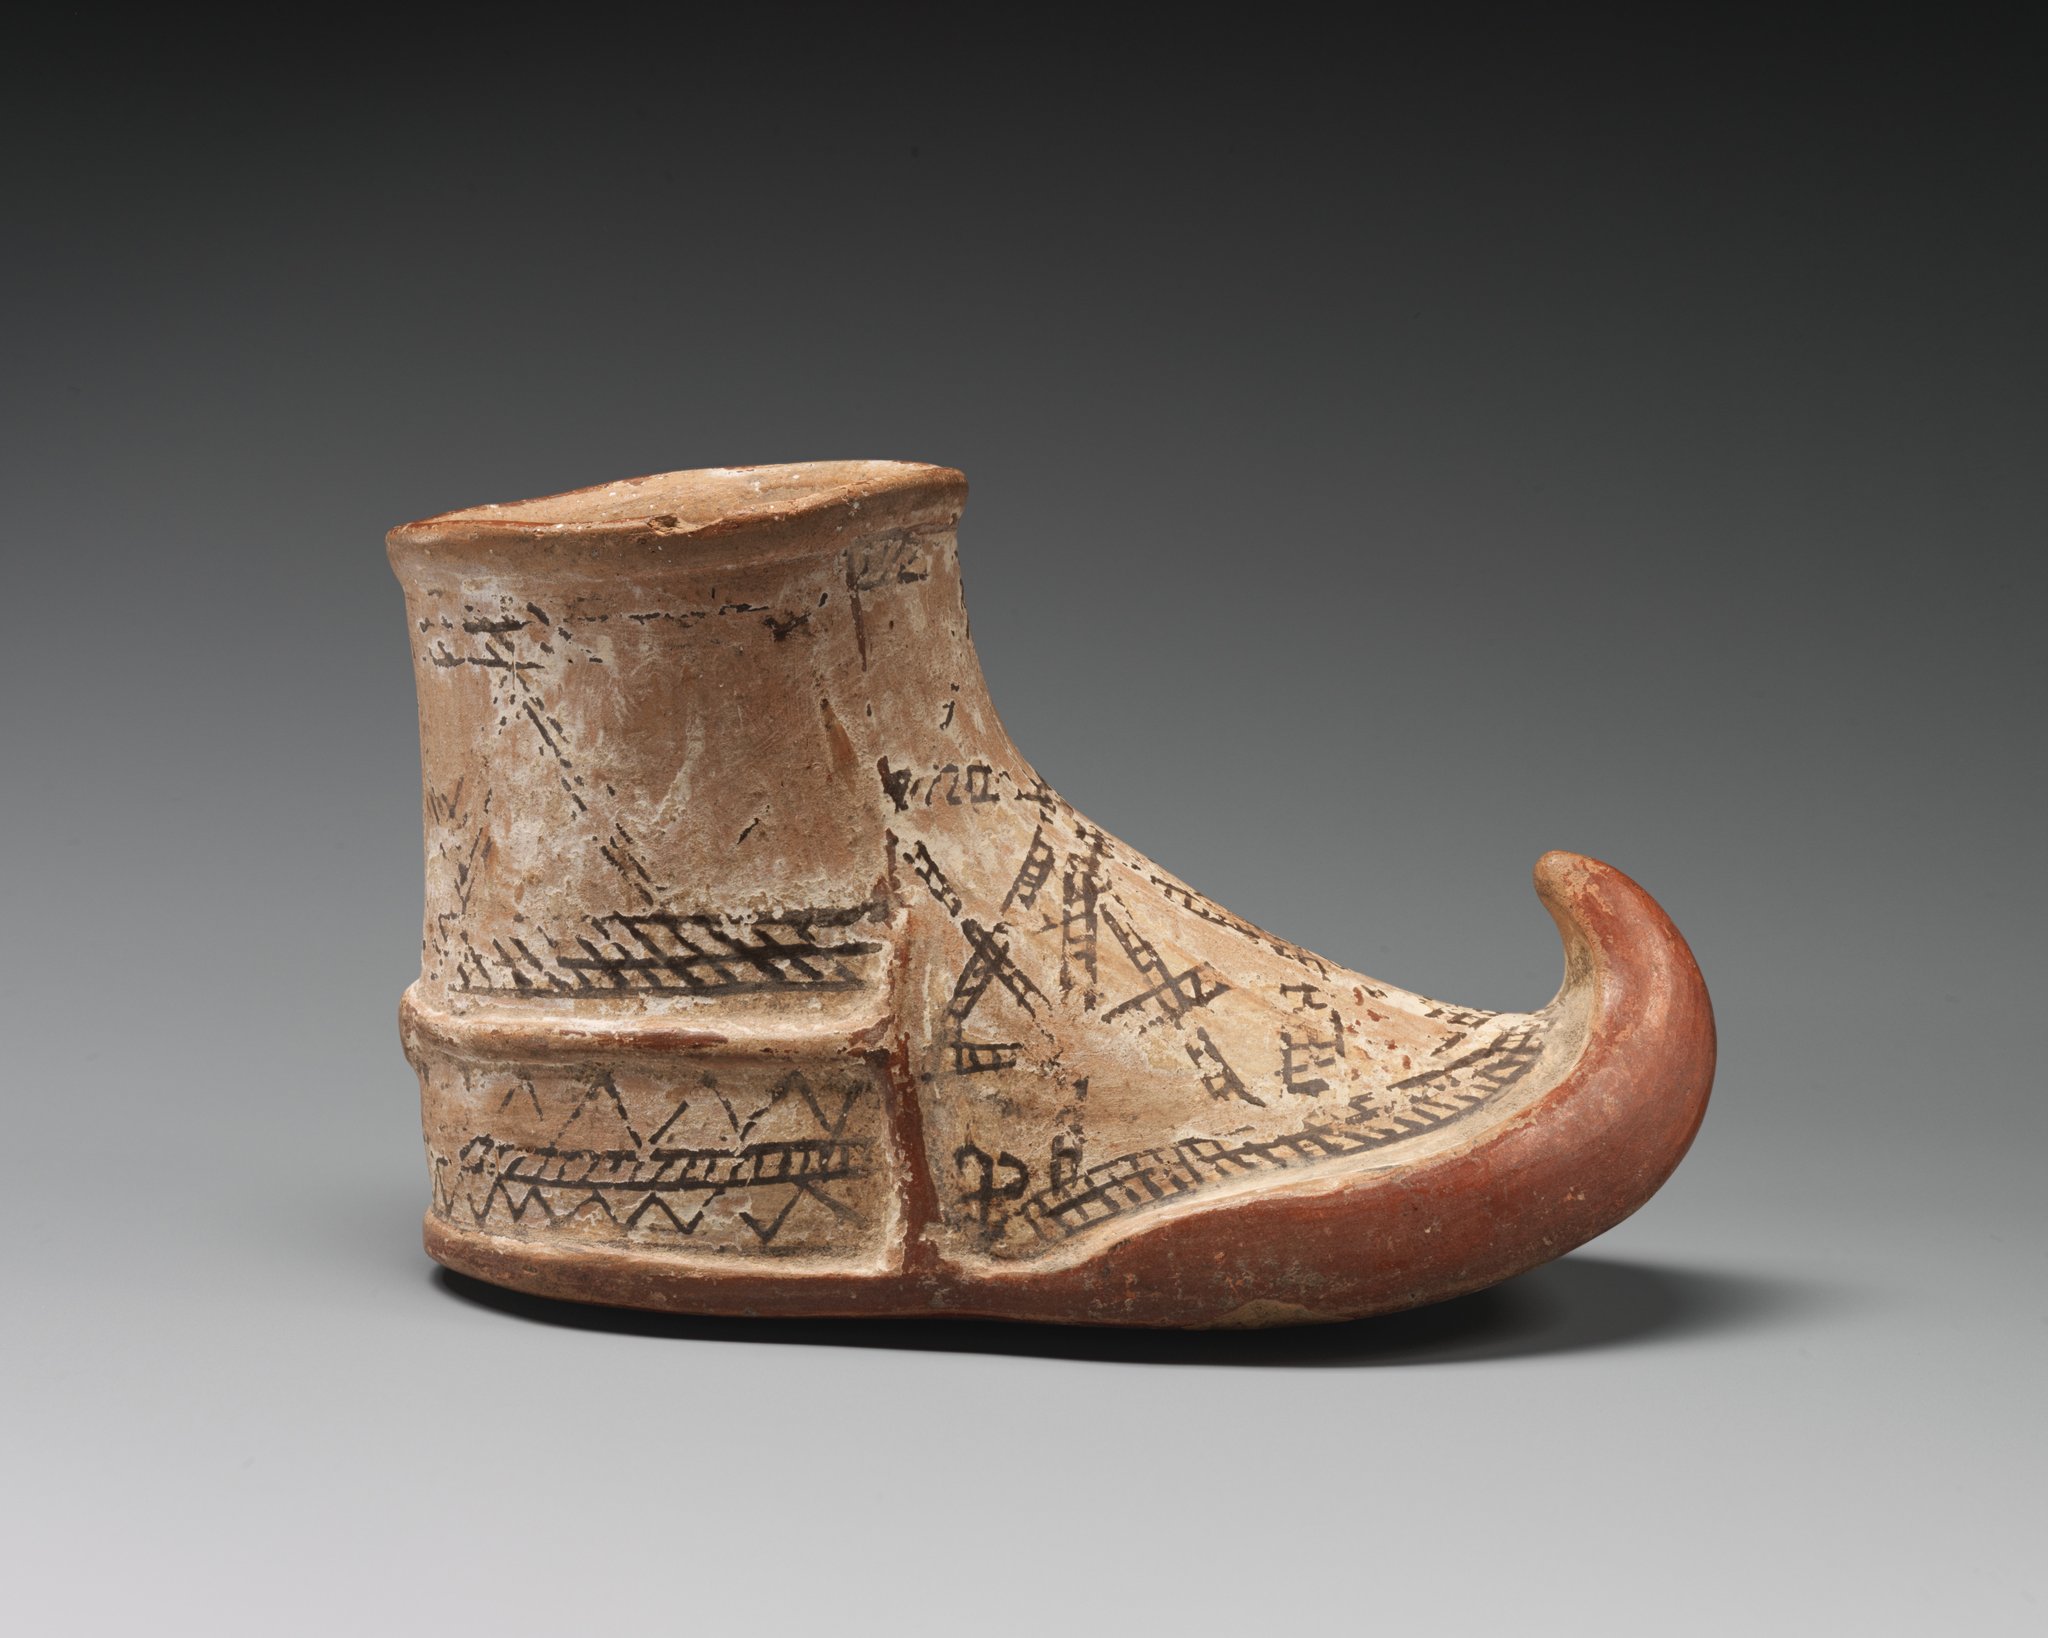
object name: vessel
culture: old assyrian or hittite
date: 1900-1600 BCE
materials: ceramic, paint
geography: central anatolia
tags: shoes